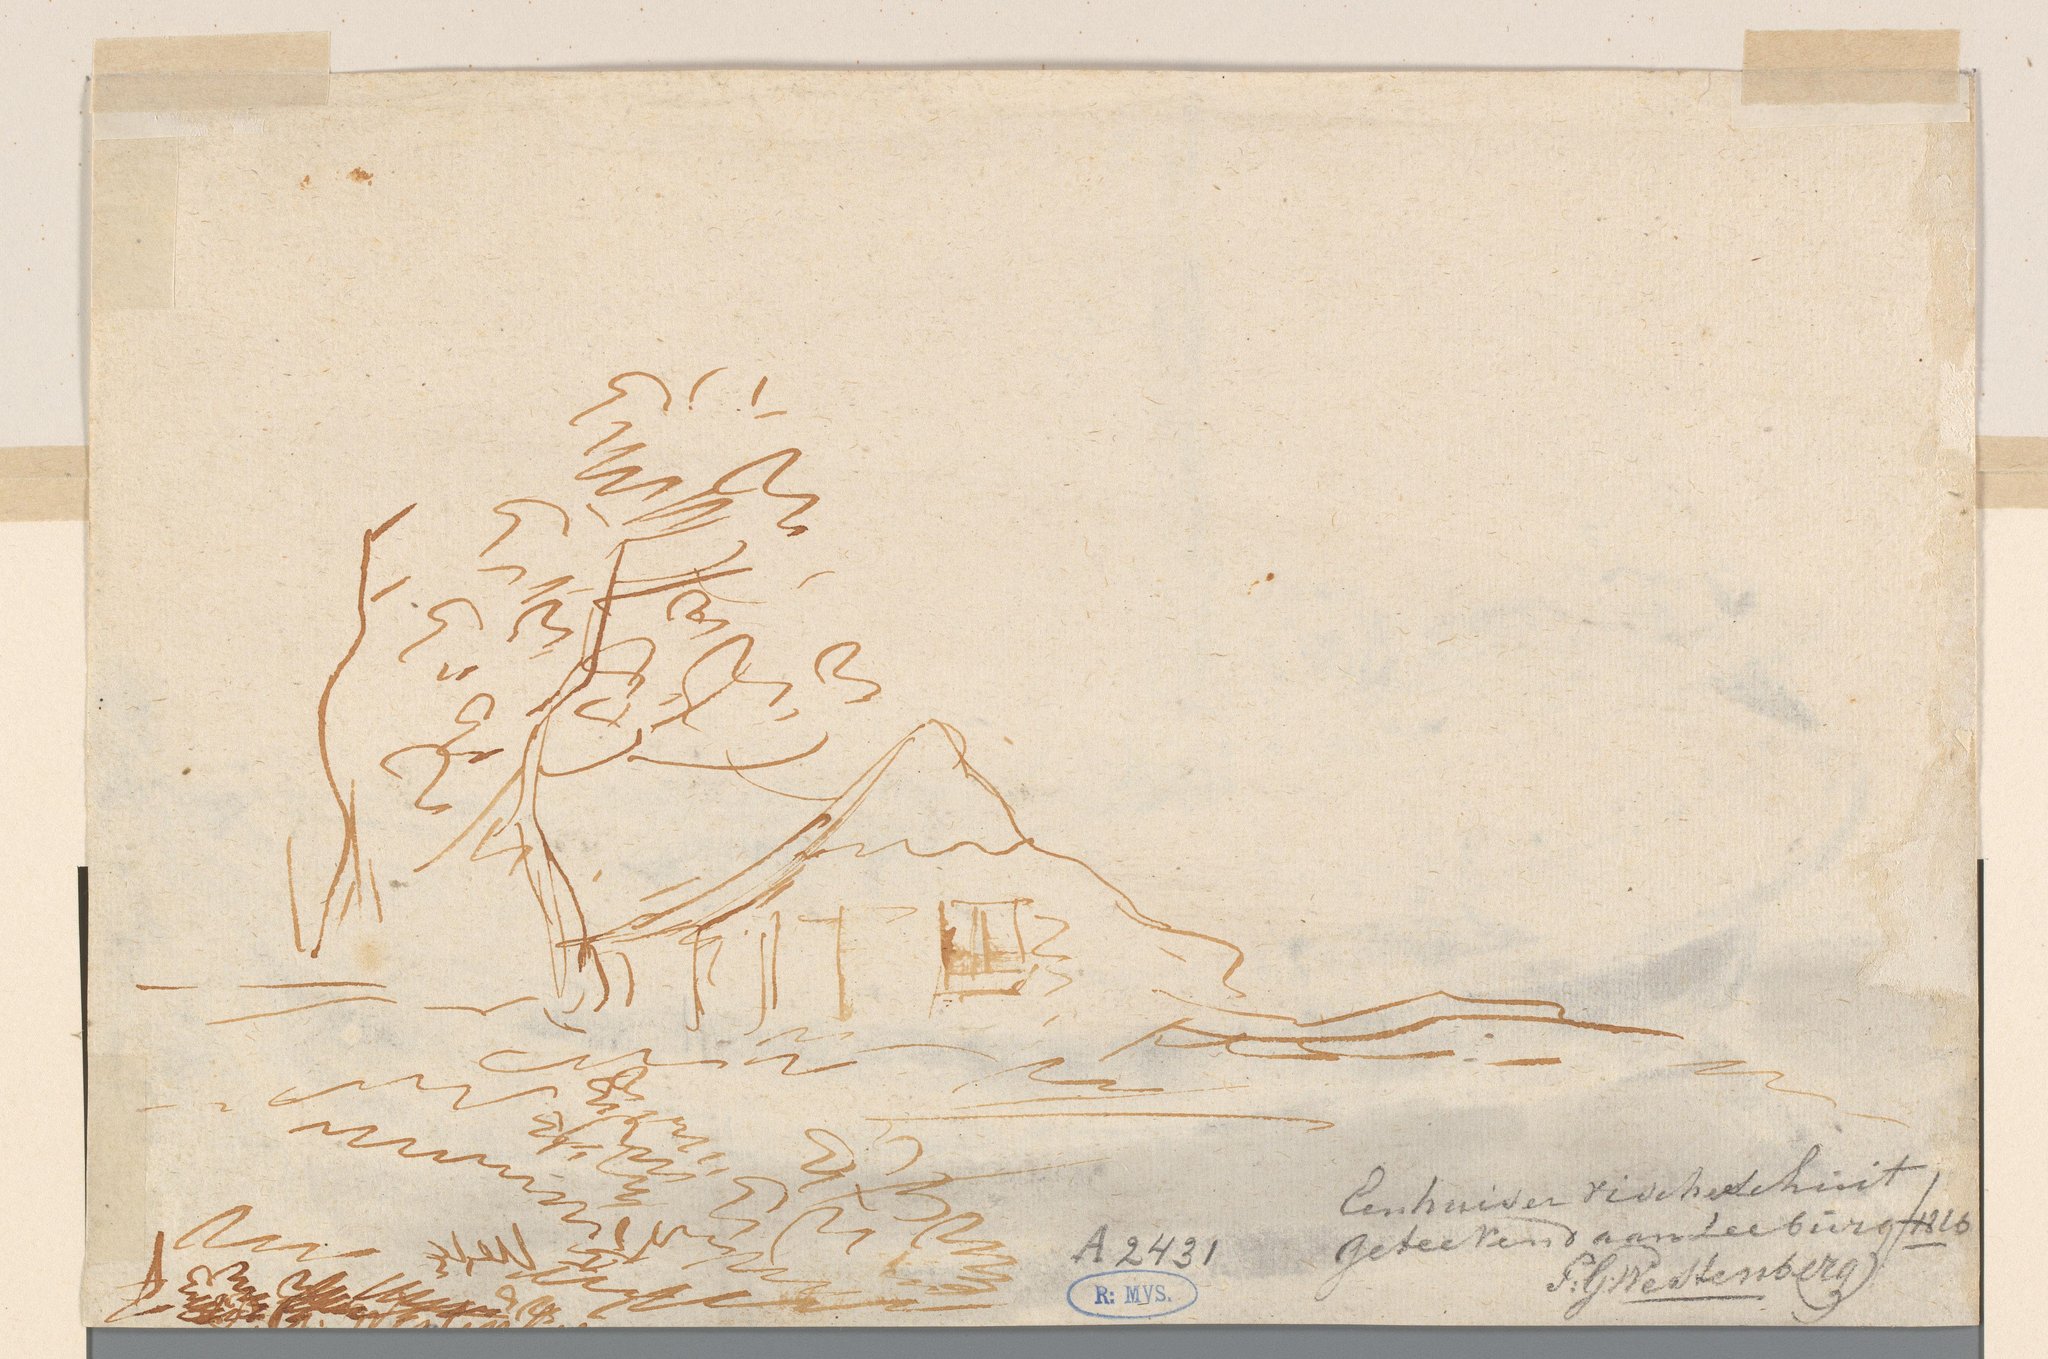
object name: drawing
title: Boerderij in een landschap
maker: george pieter westenberg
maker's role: draughtsman, painter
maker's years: 1791-1873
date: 1816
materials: ink, paper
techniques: pen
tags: farm or solitary house in landscape